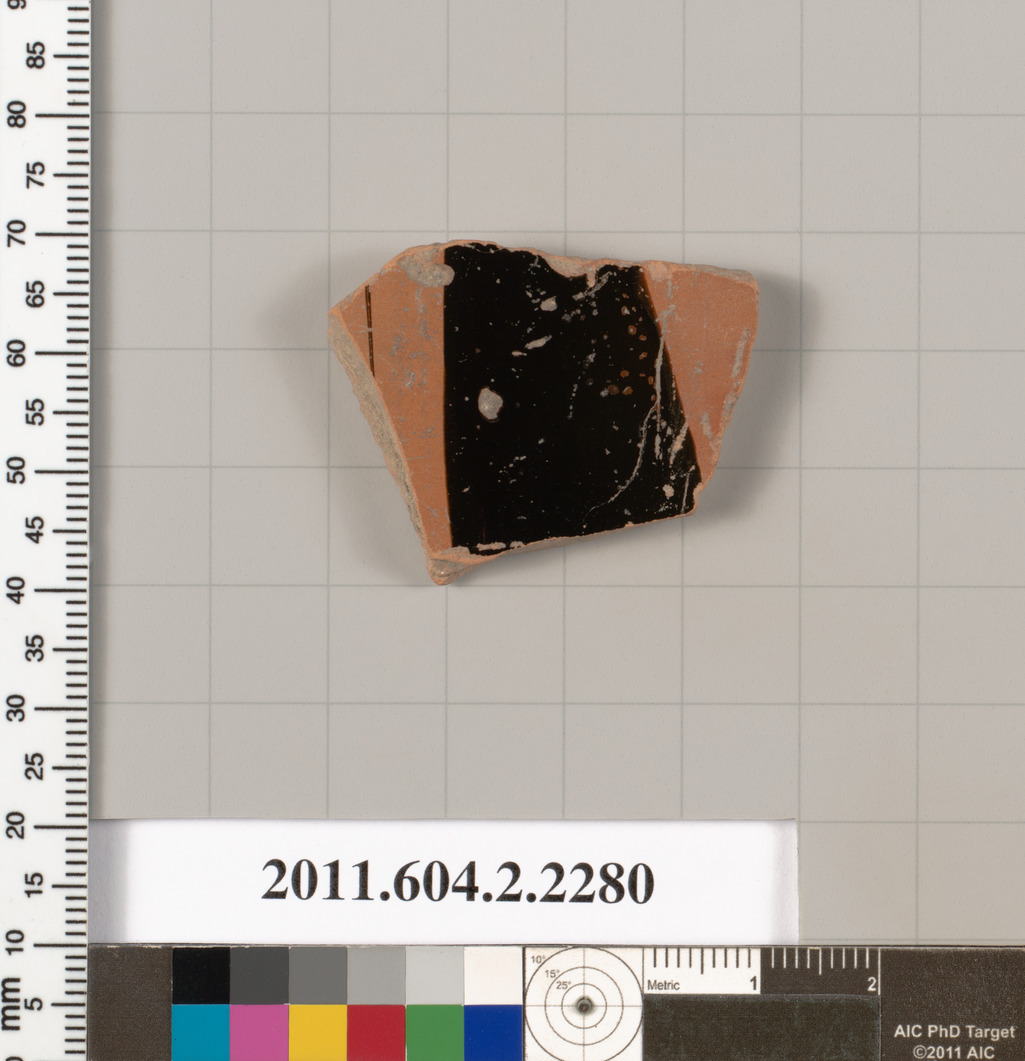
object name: pot fragment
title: Terracotta fragment of a pot; glazed on the inside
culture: greek, attic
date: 460-440 BCE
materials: terracotta